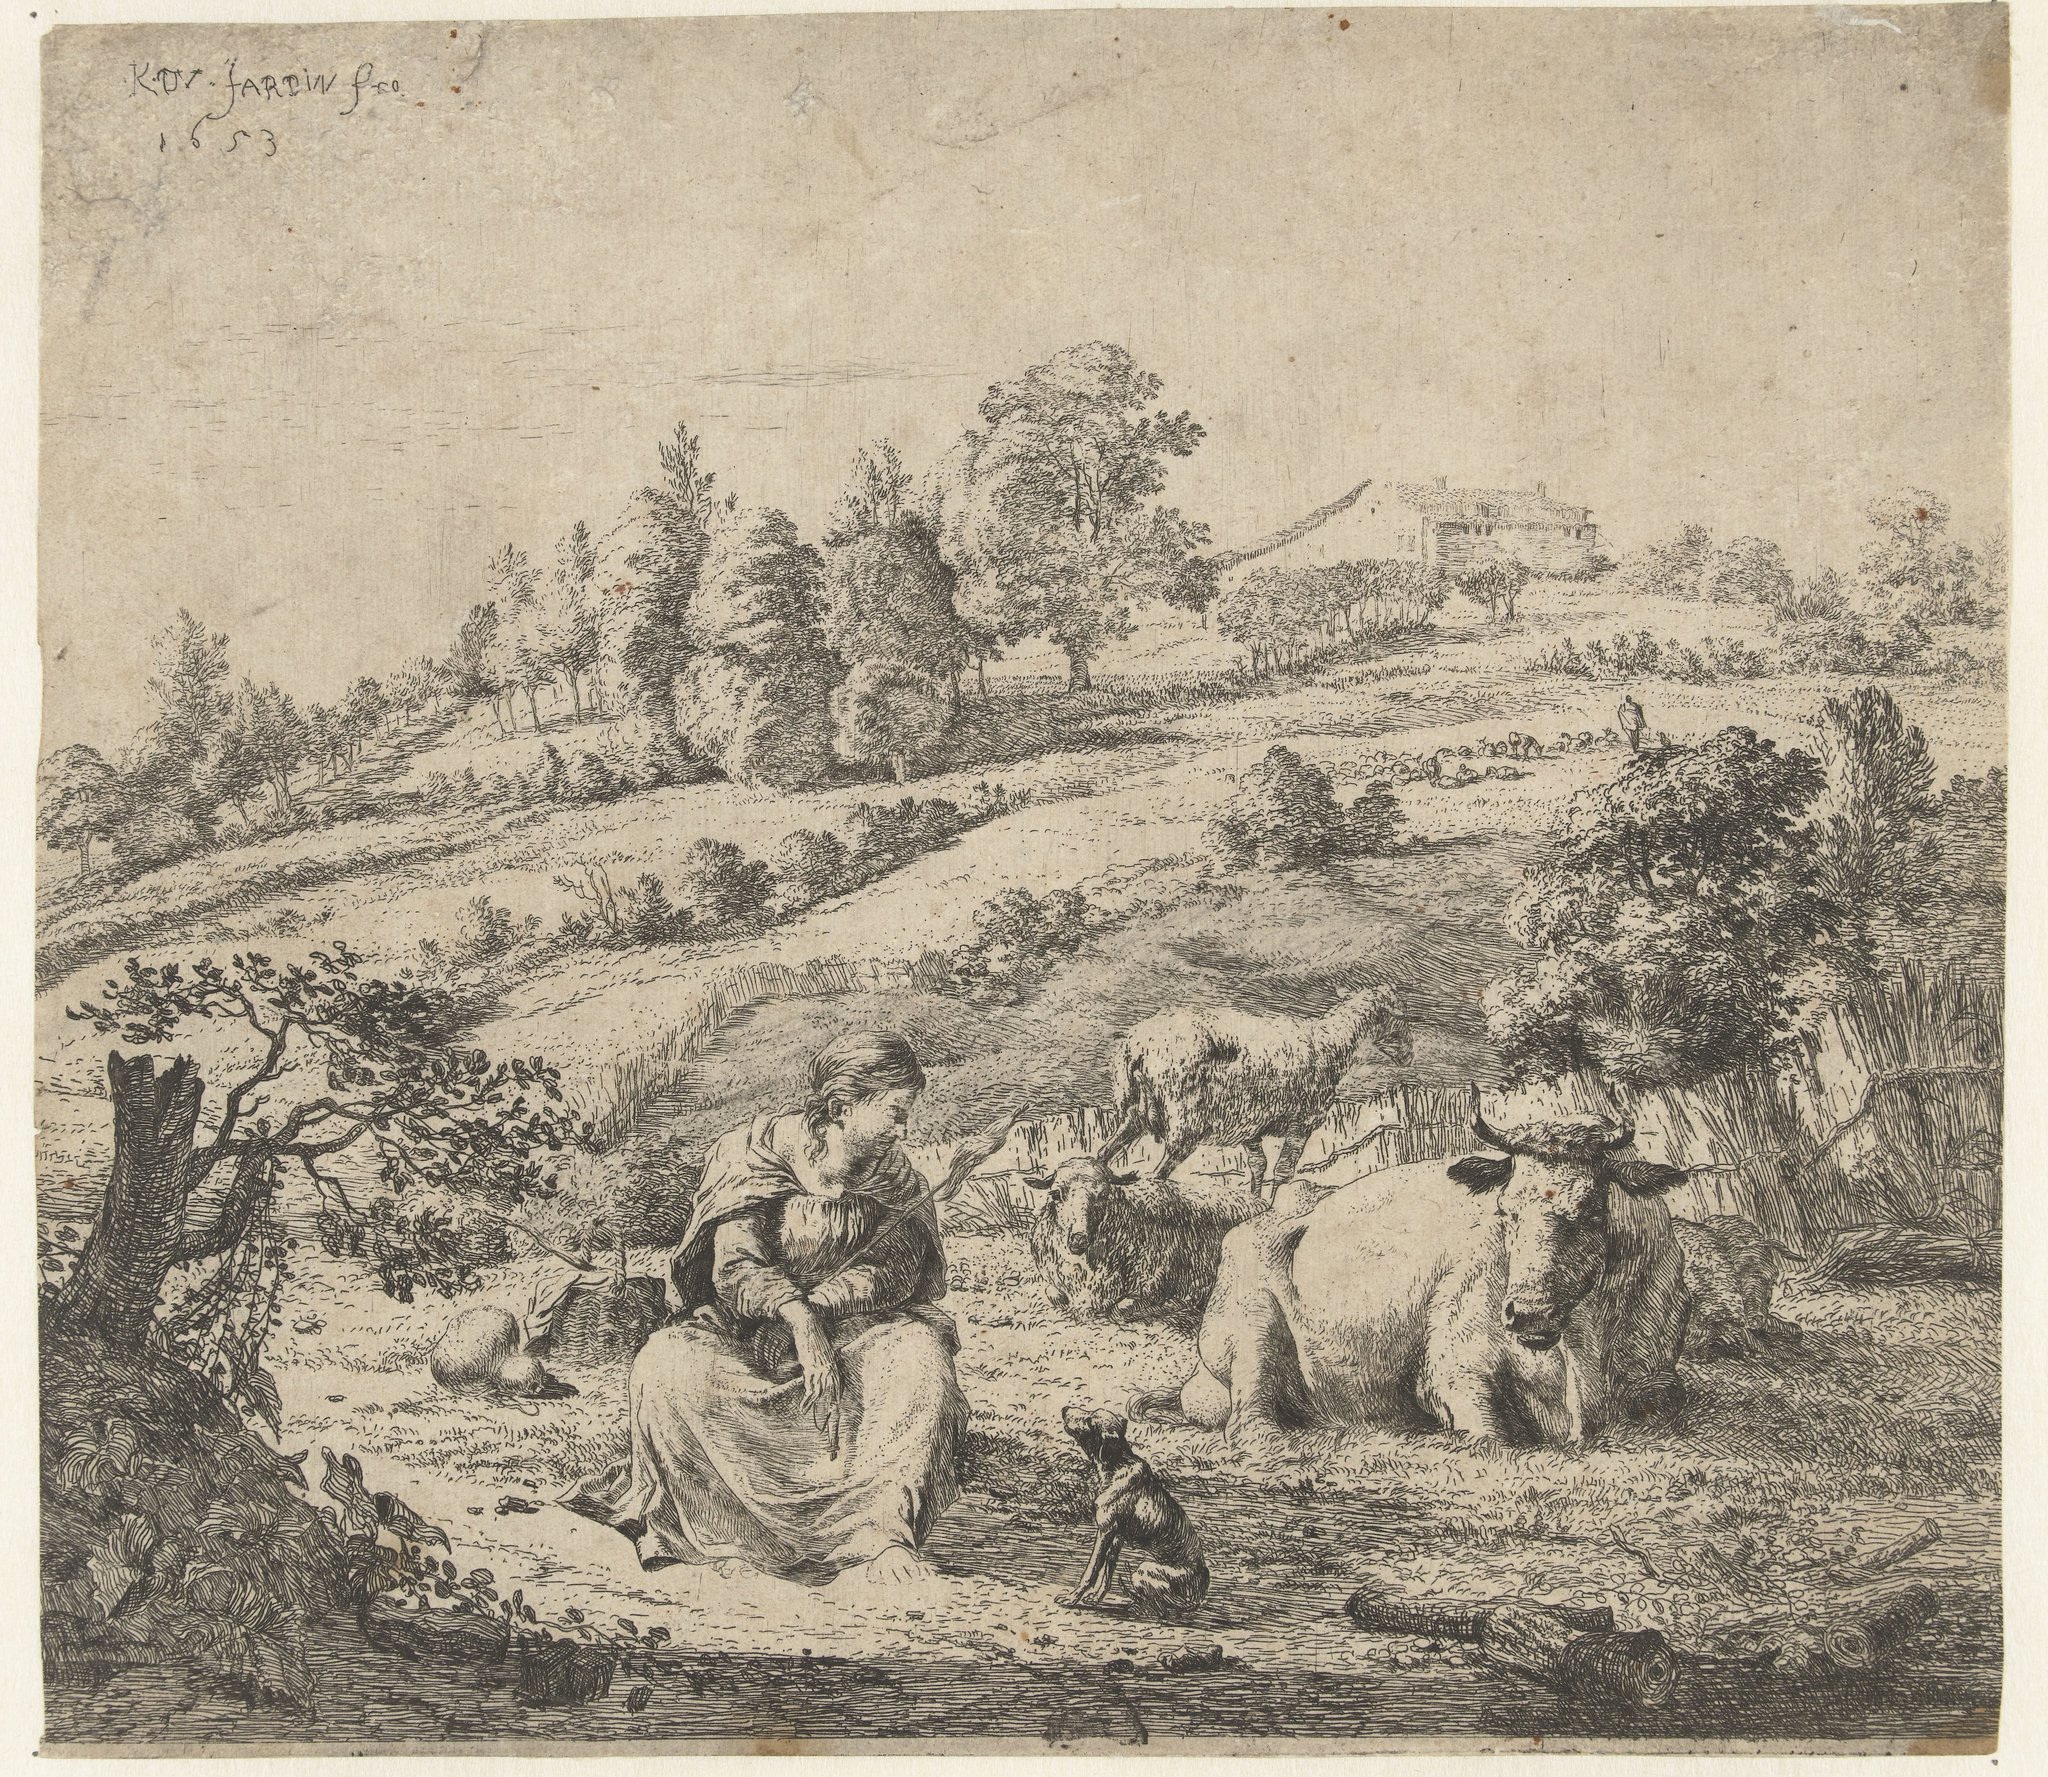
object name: print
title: Heuvellandschap met herderin en hond bij een rustende kudde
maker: karel du jardin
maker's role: draughtsman, painter, print maker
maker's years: 1626-1678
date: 1653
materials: paper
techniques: etching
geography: amsterdam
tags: herding, herdsman, herdswoman, shepherd, shepherdess, cowherd, etc., dog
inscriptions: date